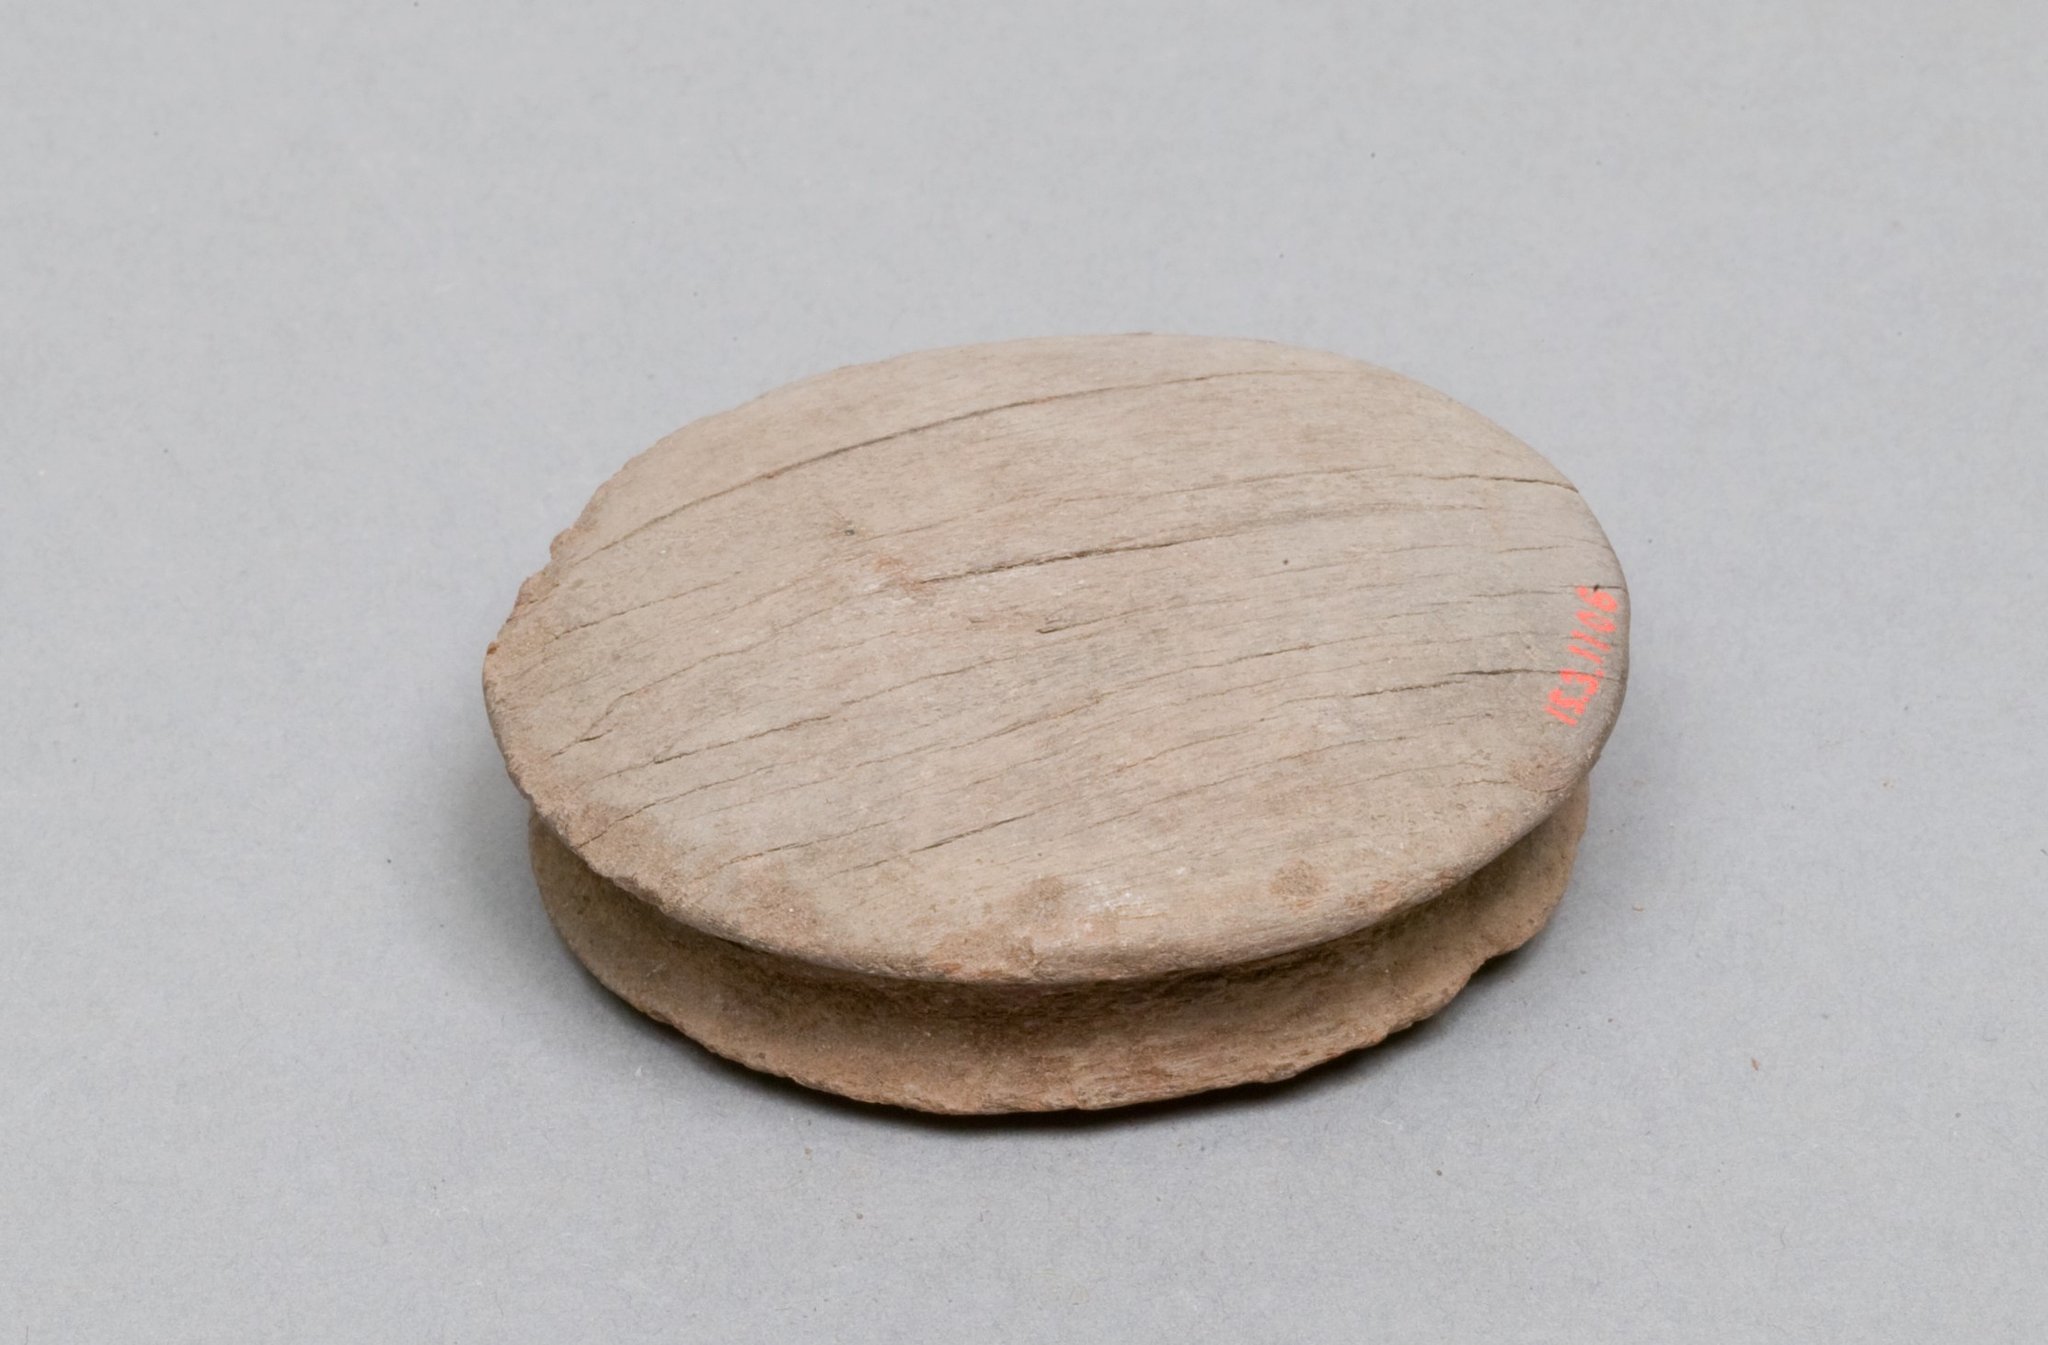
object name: reel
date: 1295-1070 BCE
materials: wood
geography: egypt